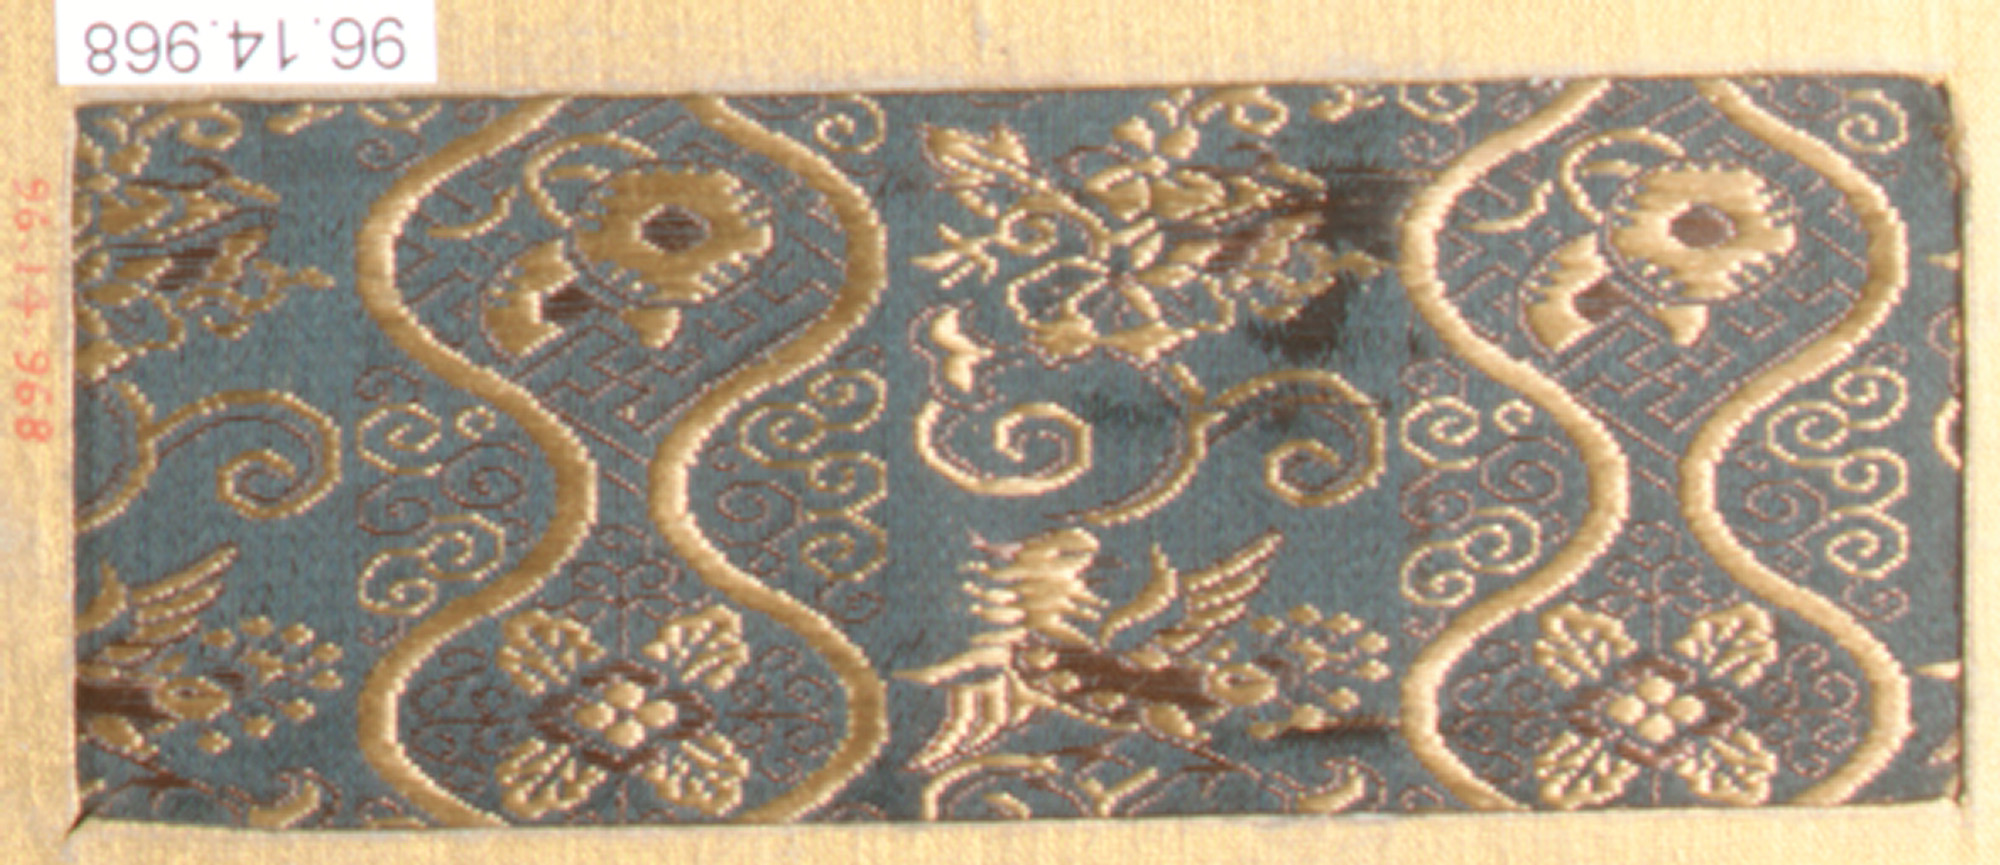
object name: piece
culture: japanese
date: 1701-1900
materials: silk